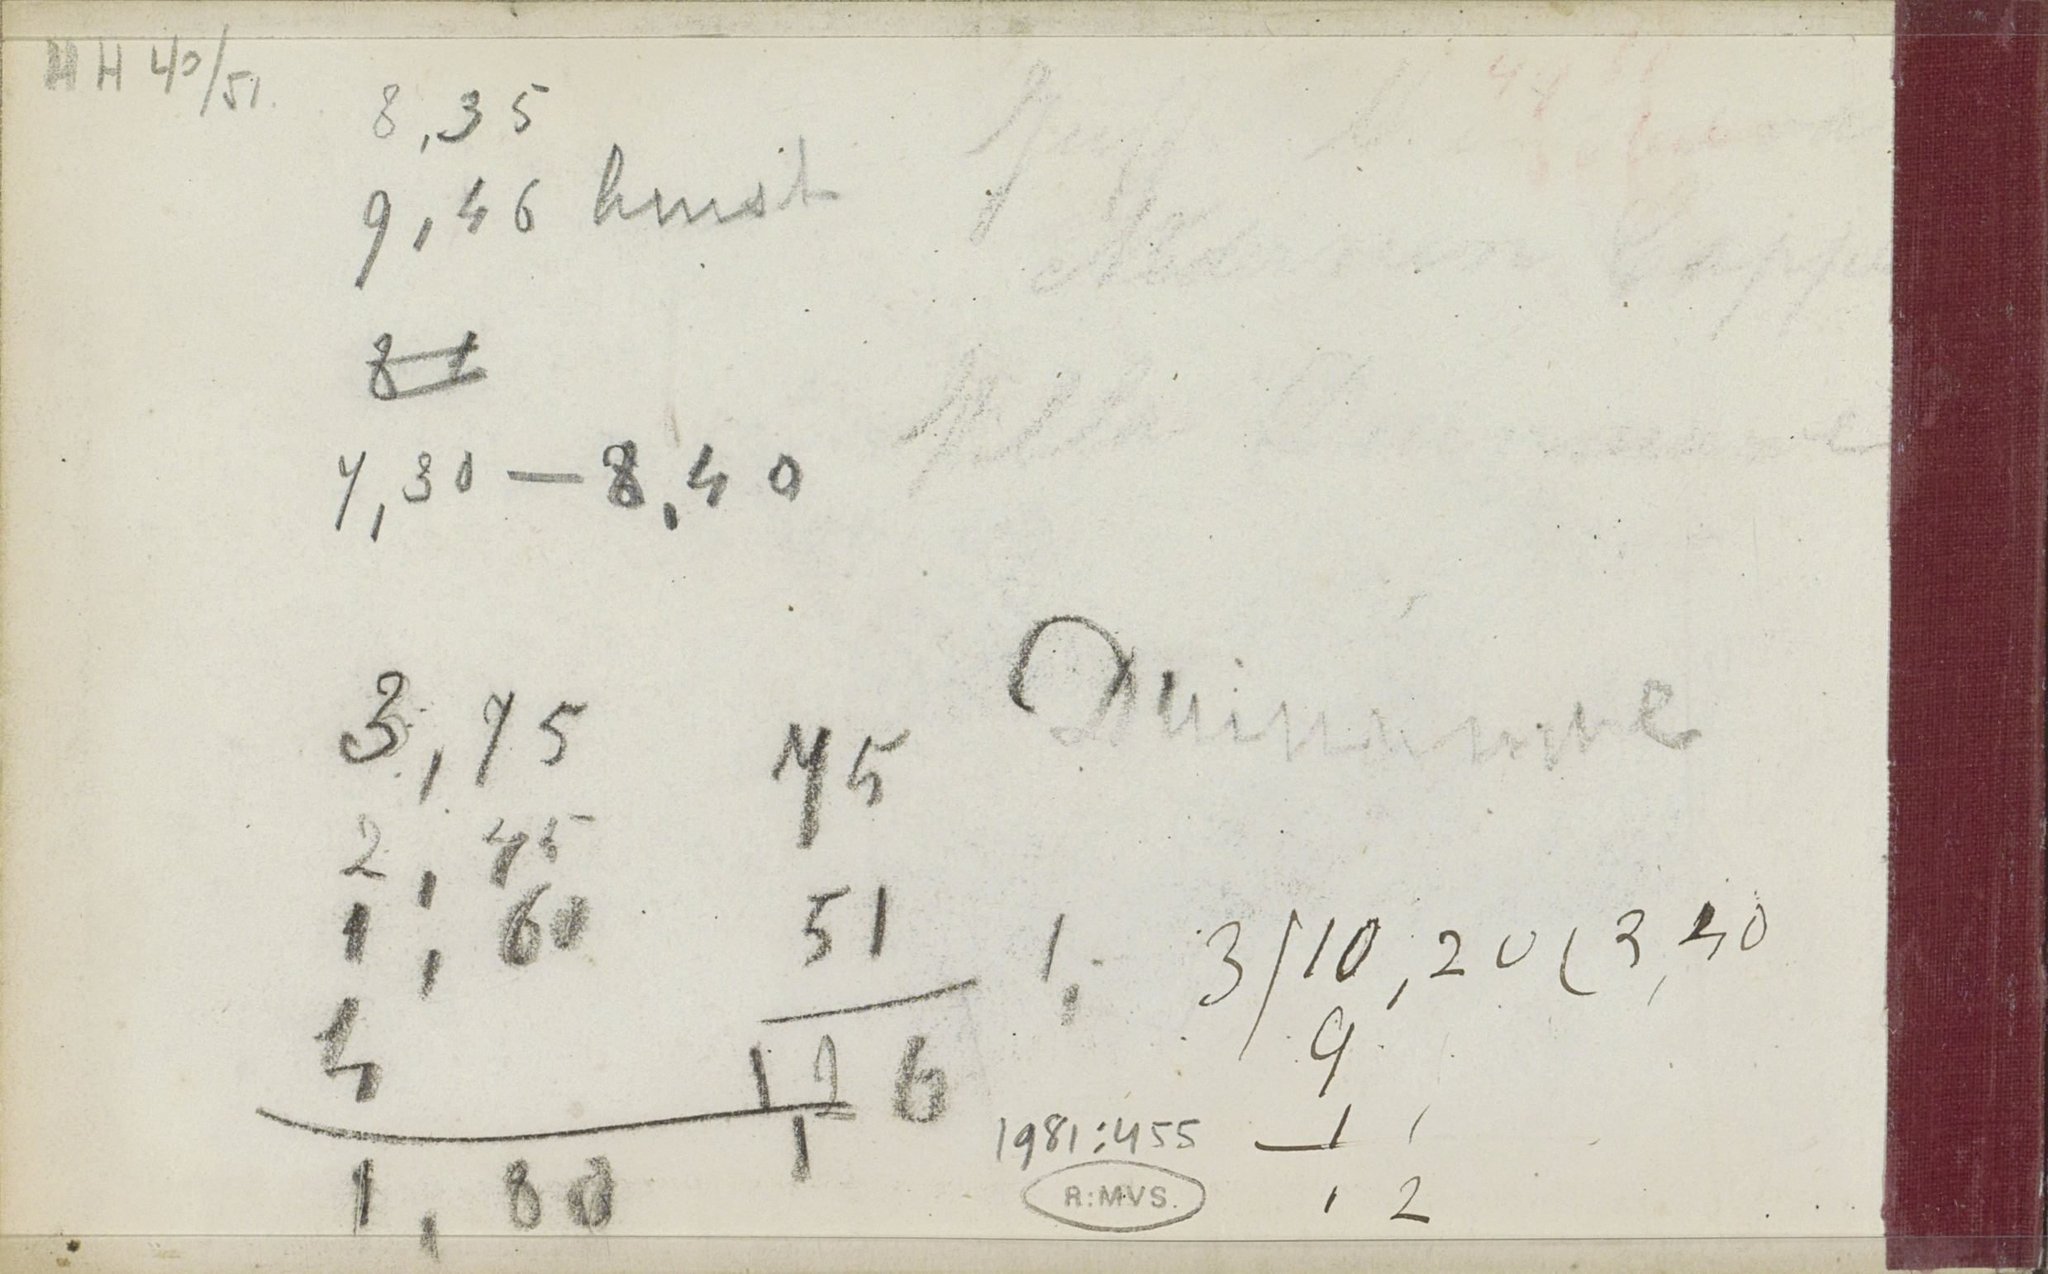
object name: endleaf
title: Notities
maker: jozef israëls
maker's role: draughtsman, painter, print maker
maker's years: 1824-1911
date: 1834-1911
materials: chalk, ink, paper, pencil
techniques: pen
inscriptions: collector's mark: Lugt 2228a, annotation: ‘kunst/ [...] Duinkerke? [...]’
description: Voorste schutblad uit een schetsboek met 37 bladen.